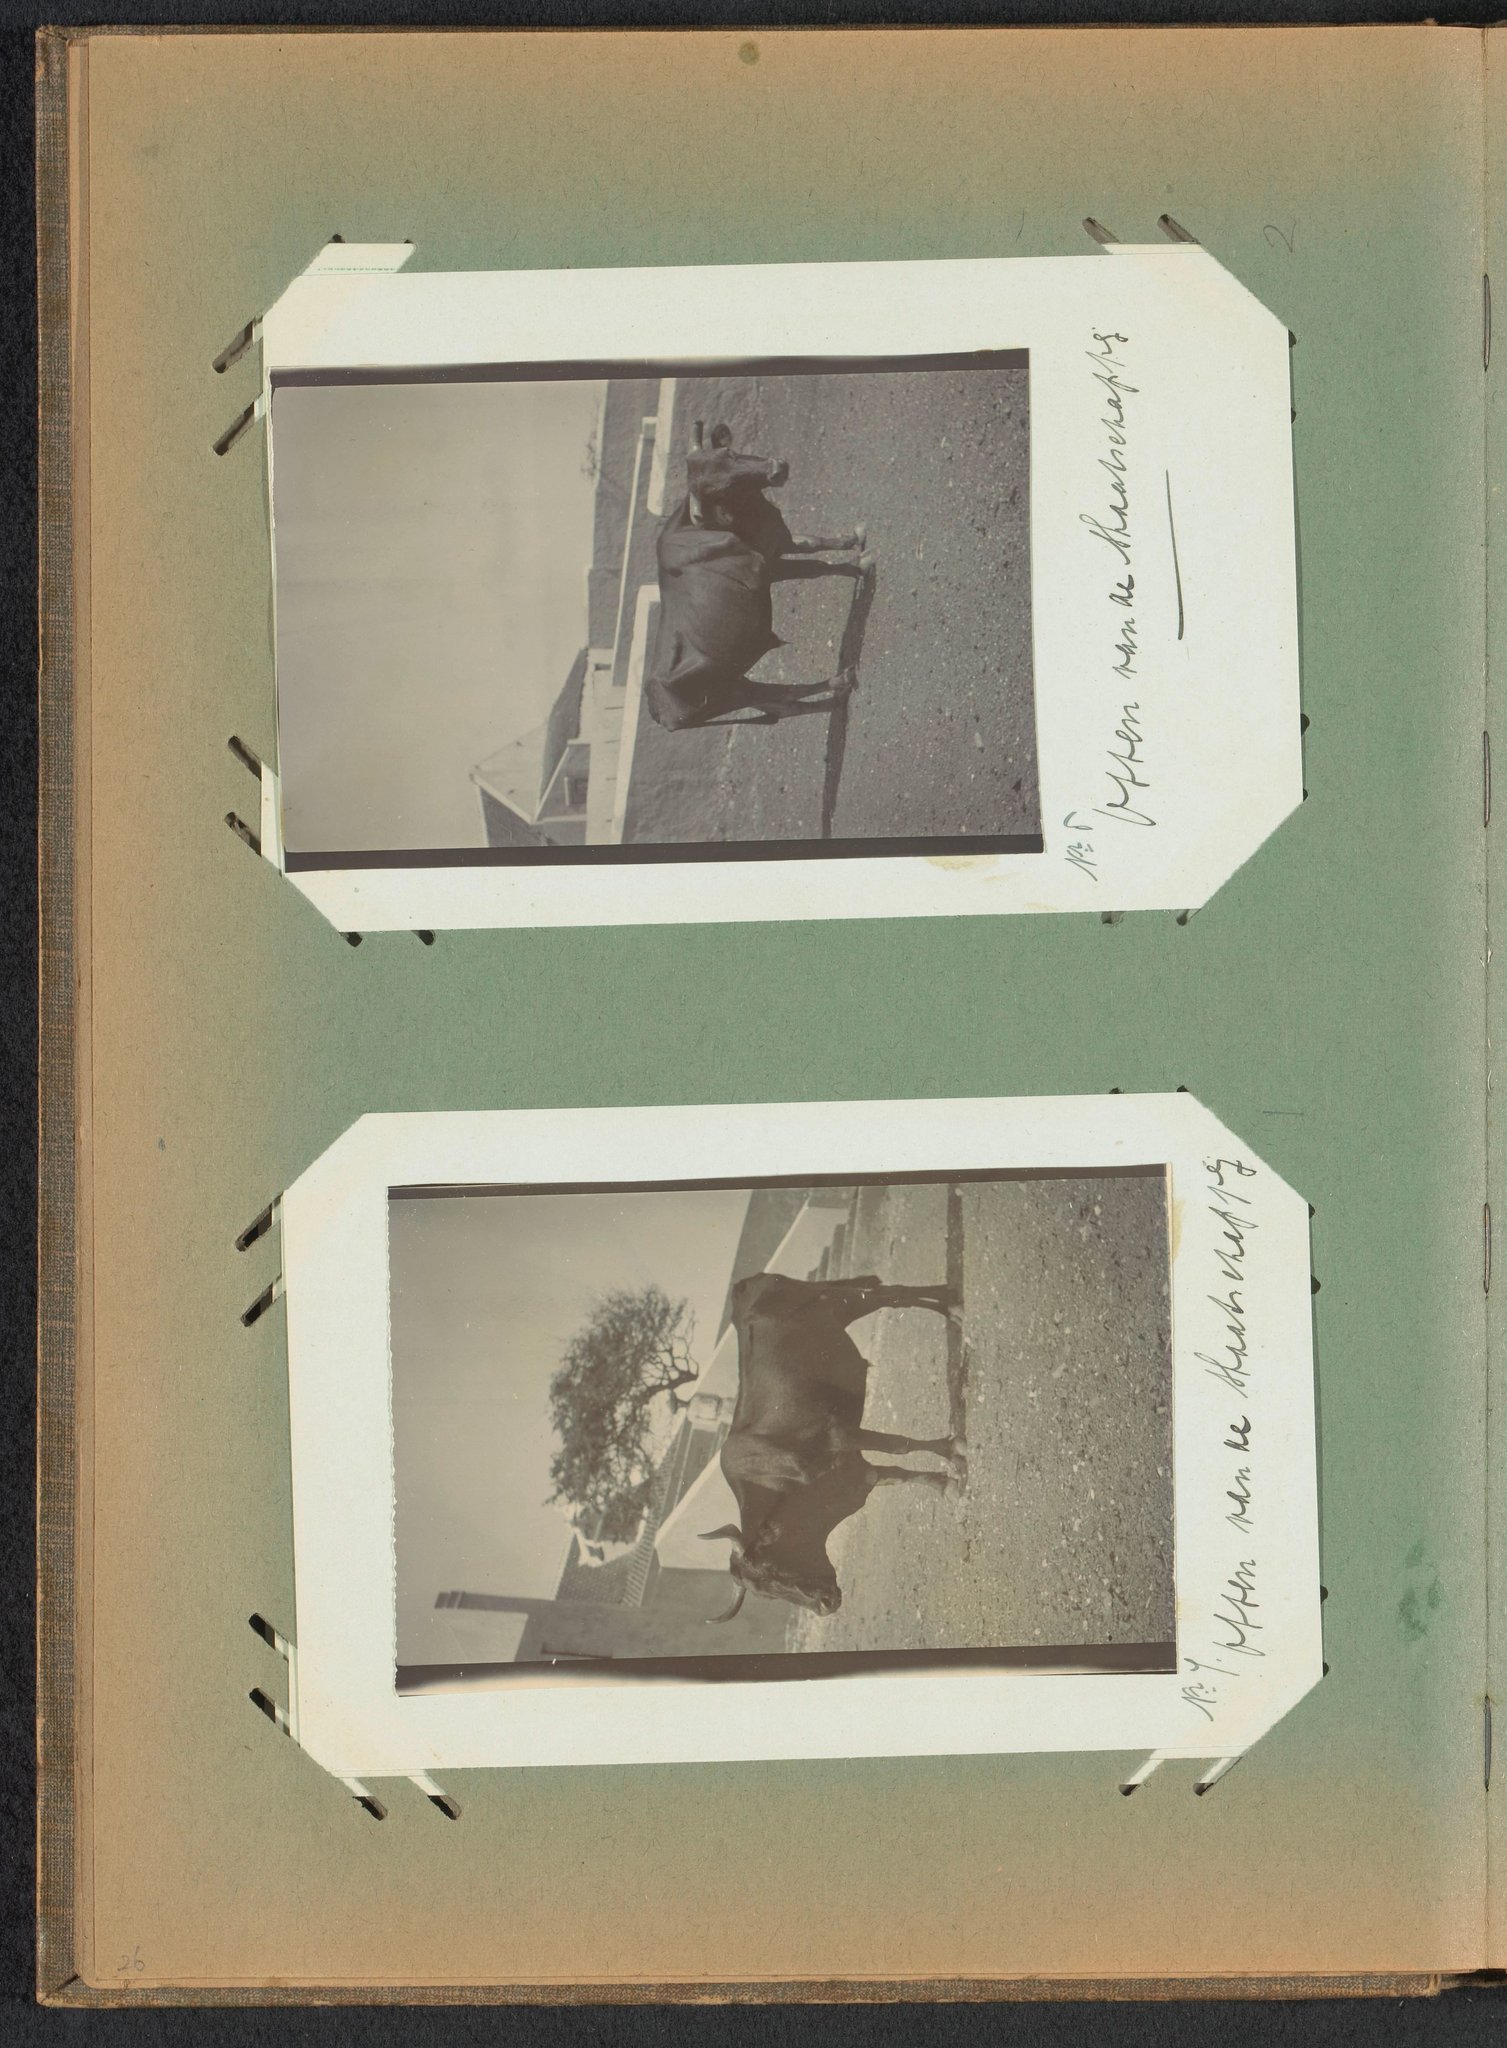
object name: photograph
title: Os behorend bij Mount Pleasant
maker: Anonymous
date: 1912-1913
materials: paper, photographic support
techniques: gelatin silver print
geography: curacao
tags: plantation, ox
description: Os van de plantage Mount Pleasant op Curaçao. Onderdeel van het fotoalbum uit ca. 1912-1913 met 92 foto's van de plantages Peperpot en Dordrecht in Suriname en Mount Pleasant op Curaçao.